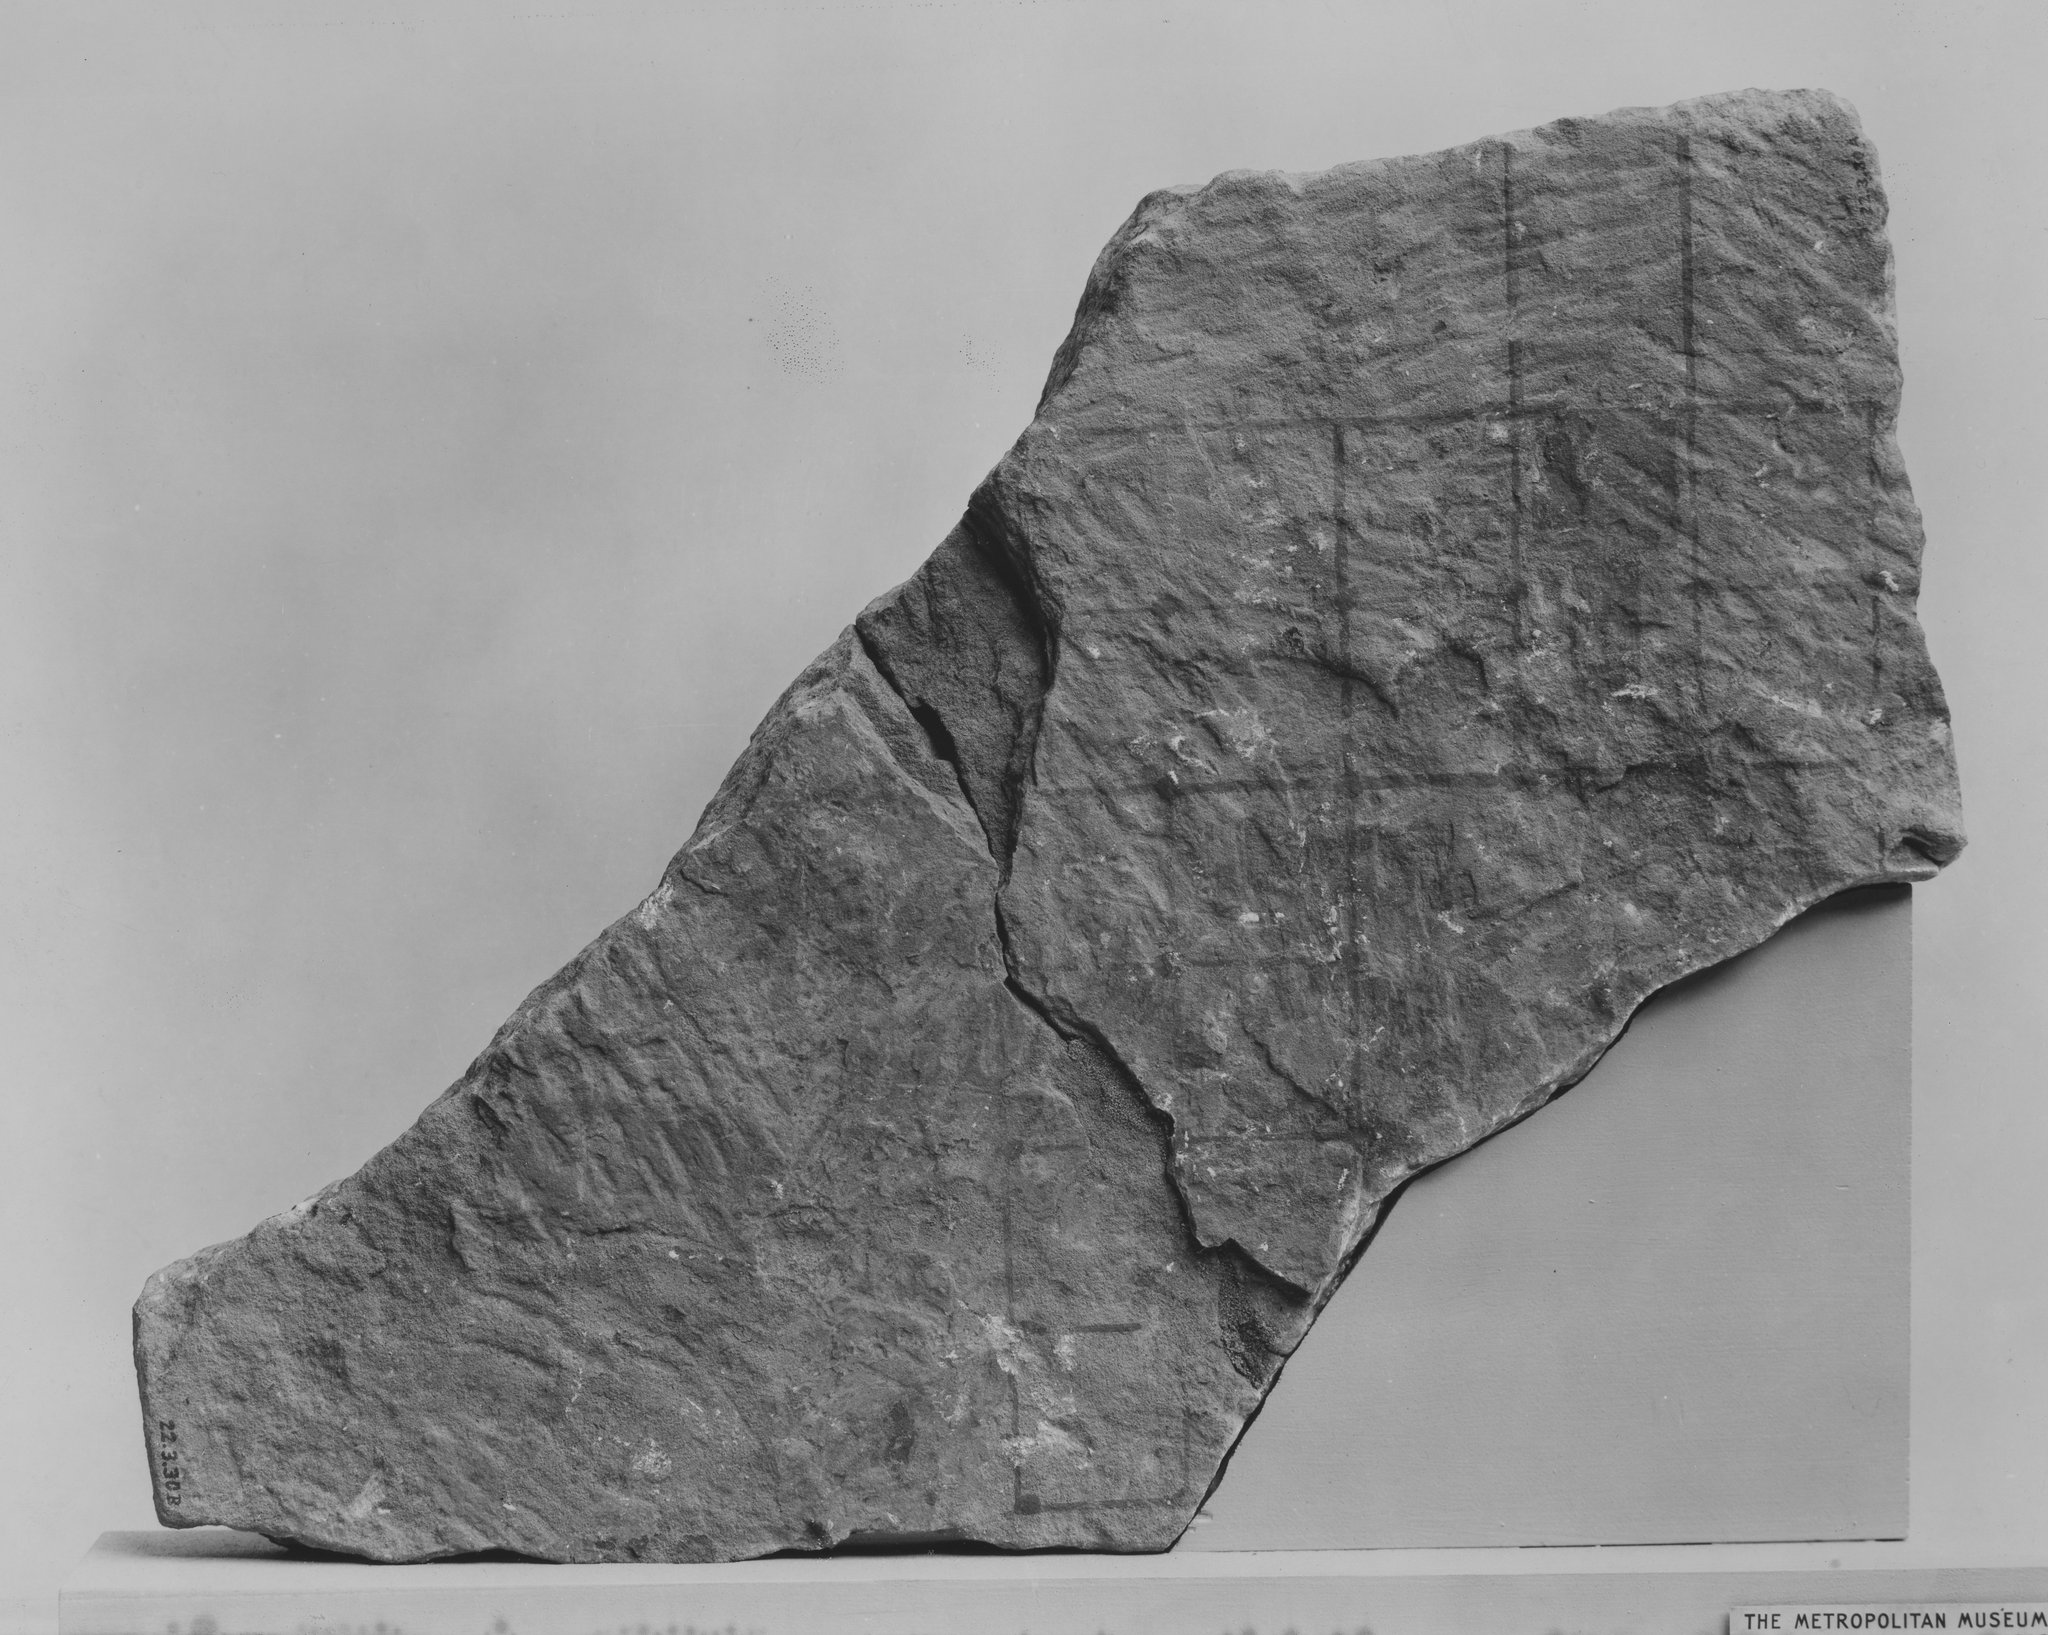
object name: trial piece, temple garden plan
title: Plan for a temple garden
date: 2030-1640 BCE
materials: stone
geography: egypt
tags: gardens